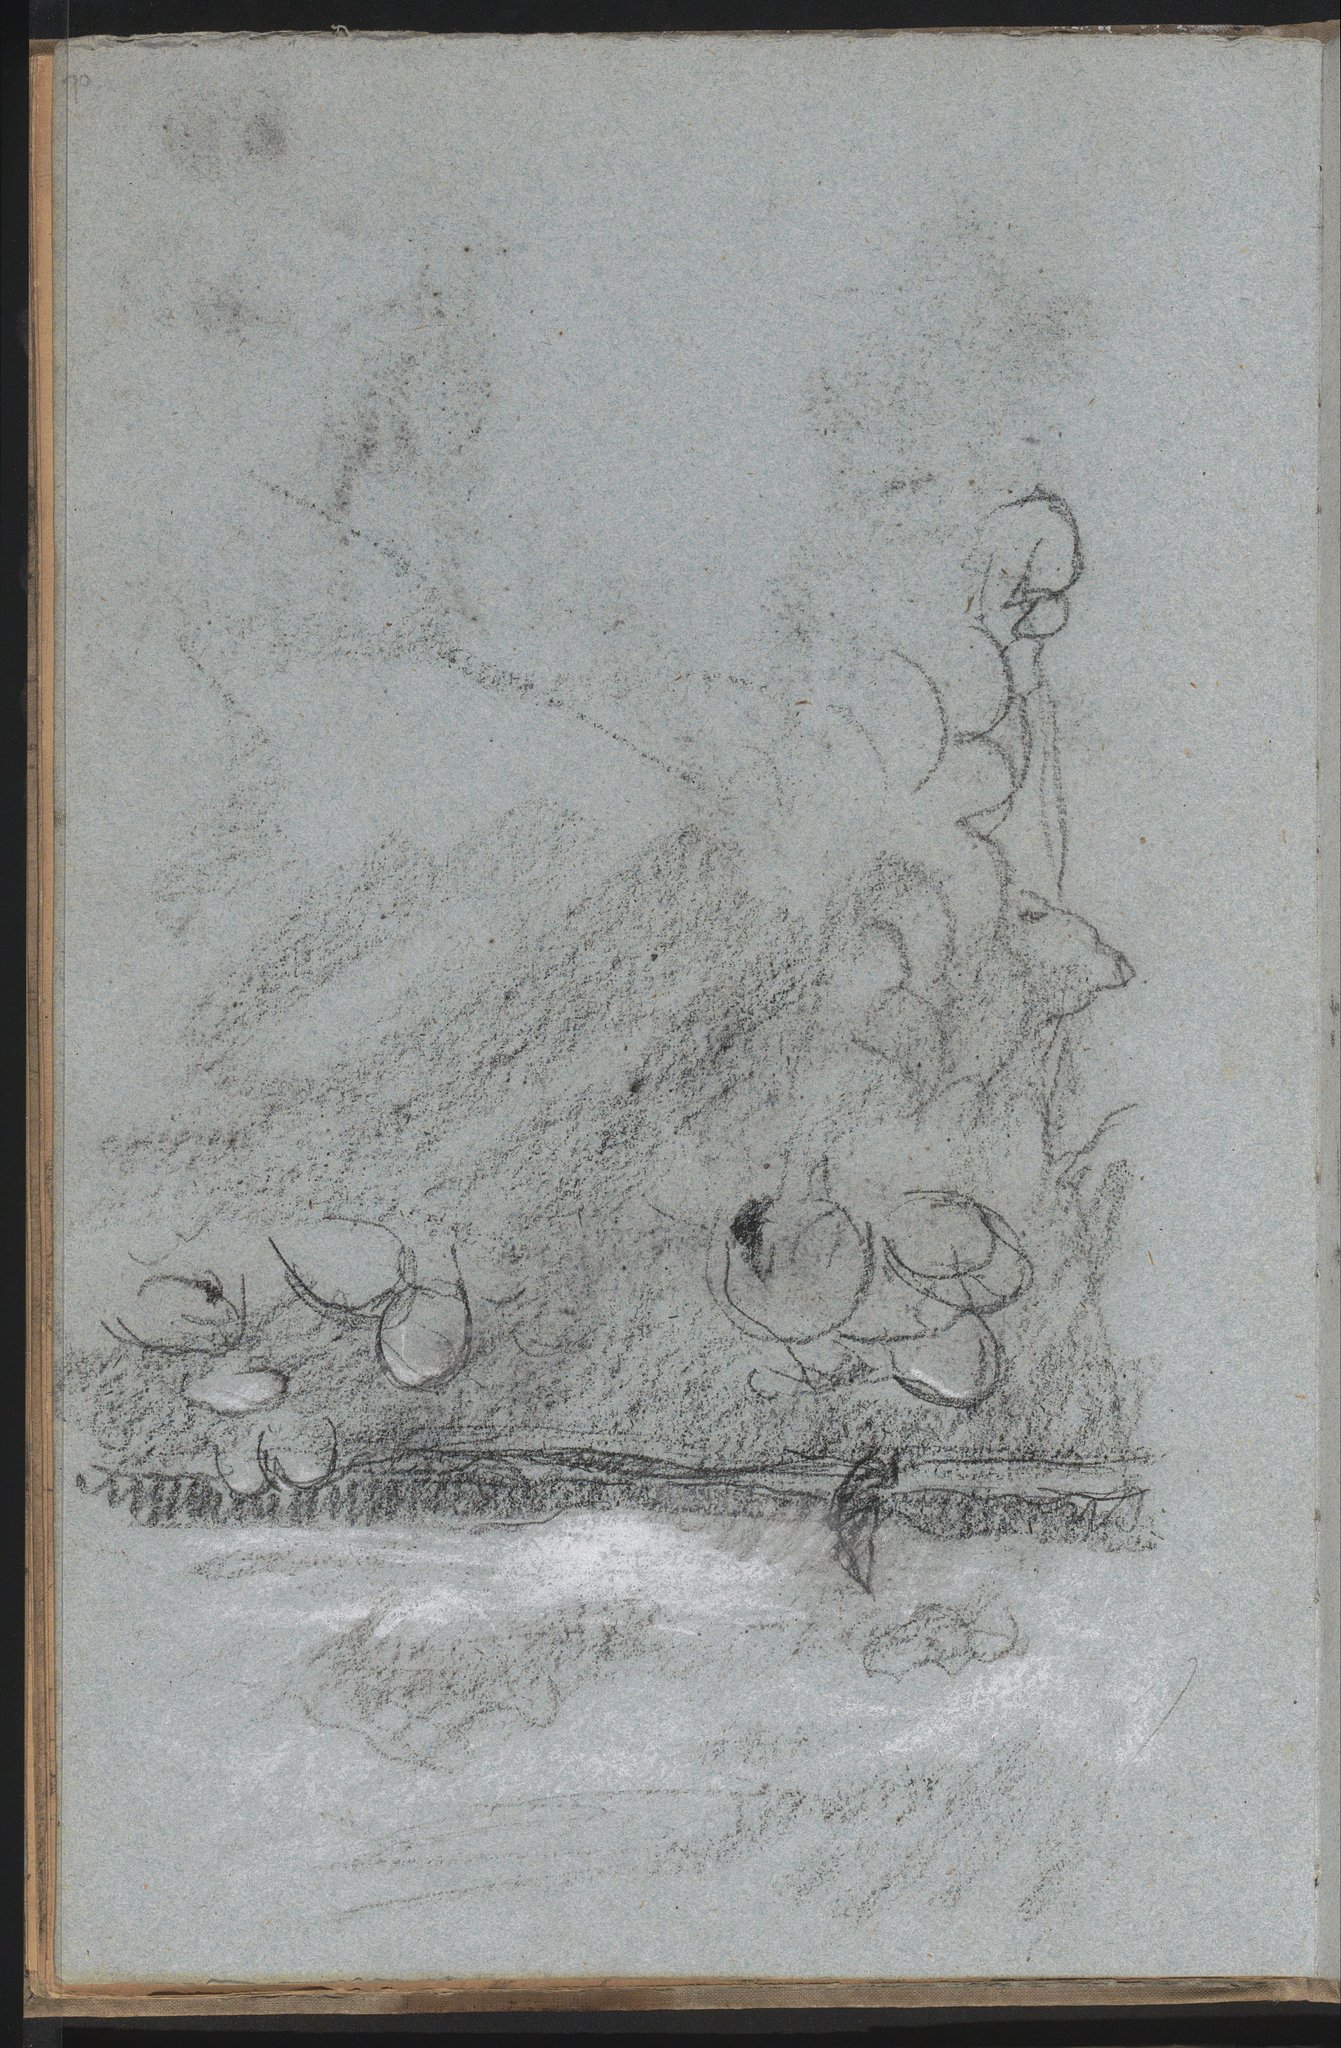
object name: sketchbook leaf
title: Landschap met een kudde schapen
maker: willem witsen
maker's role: draughtsman, painter, print maker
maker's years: 1860-1923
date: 1884-1887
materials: chalk, paper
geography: ewijkshoeve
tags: landscapes in the temperate zone, sheep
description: Pagina 70 uit een schetsboek met 45 bladen vervaardigd rond de Ewijkshoeve.